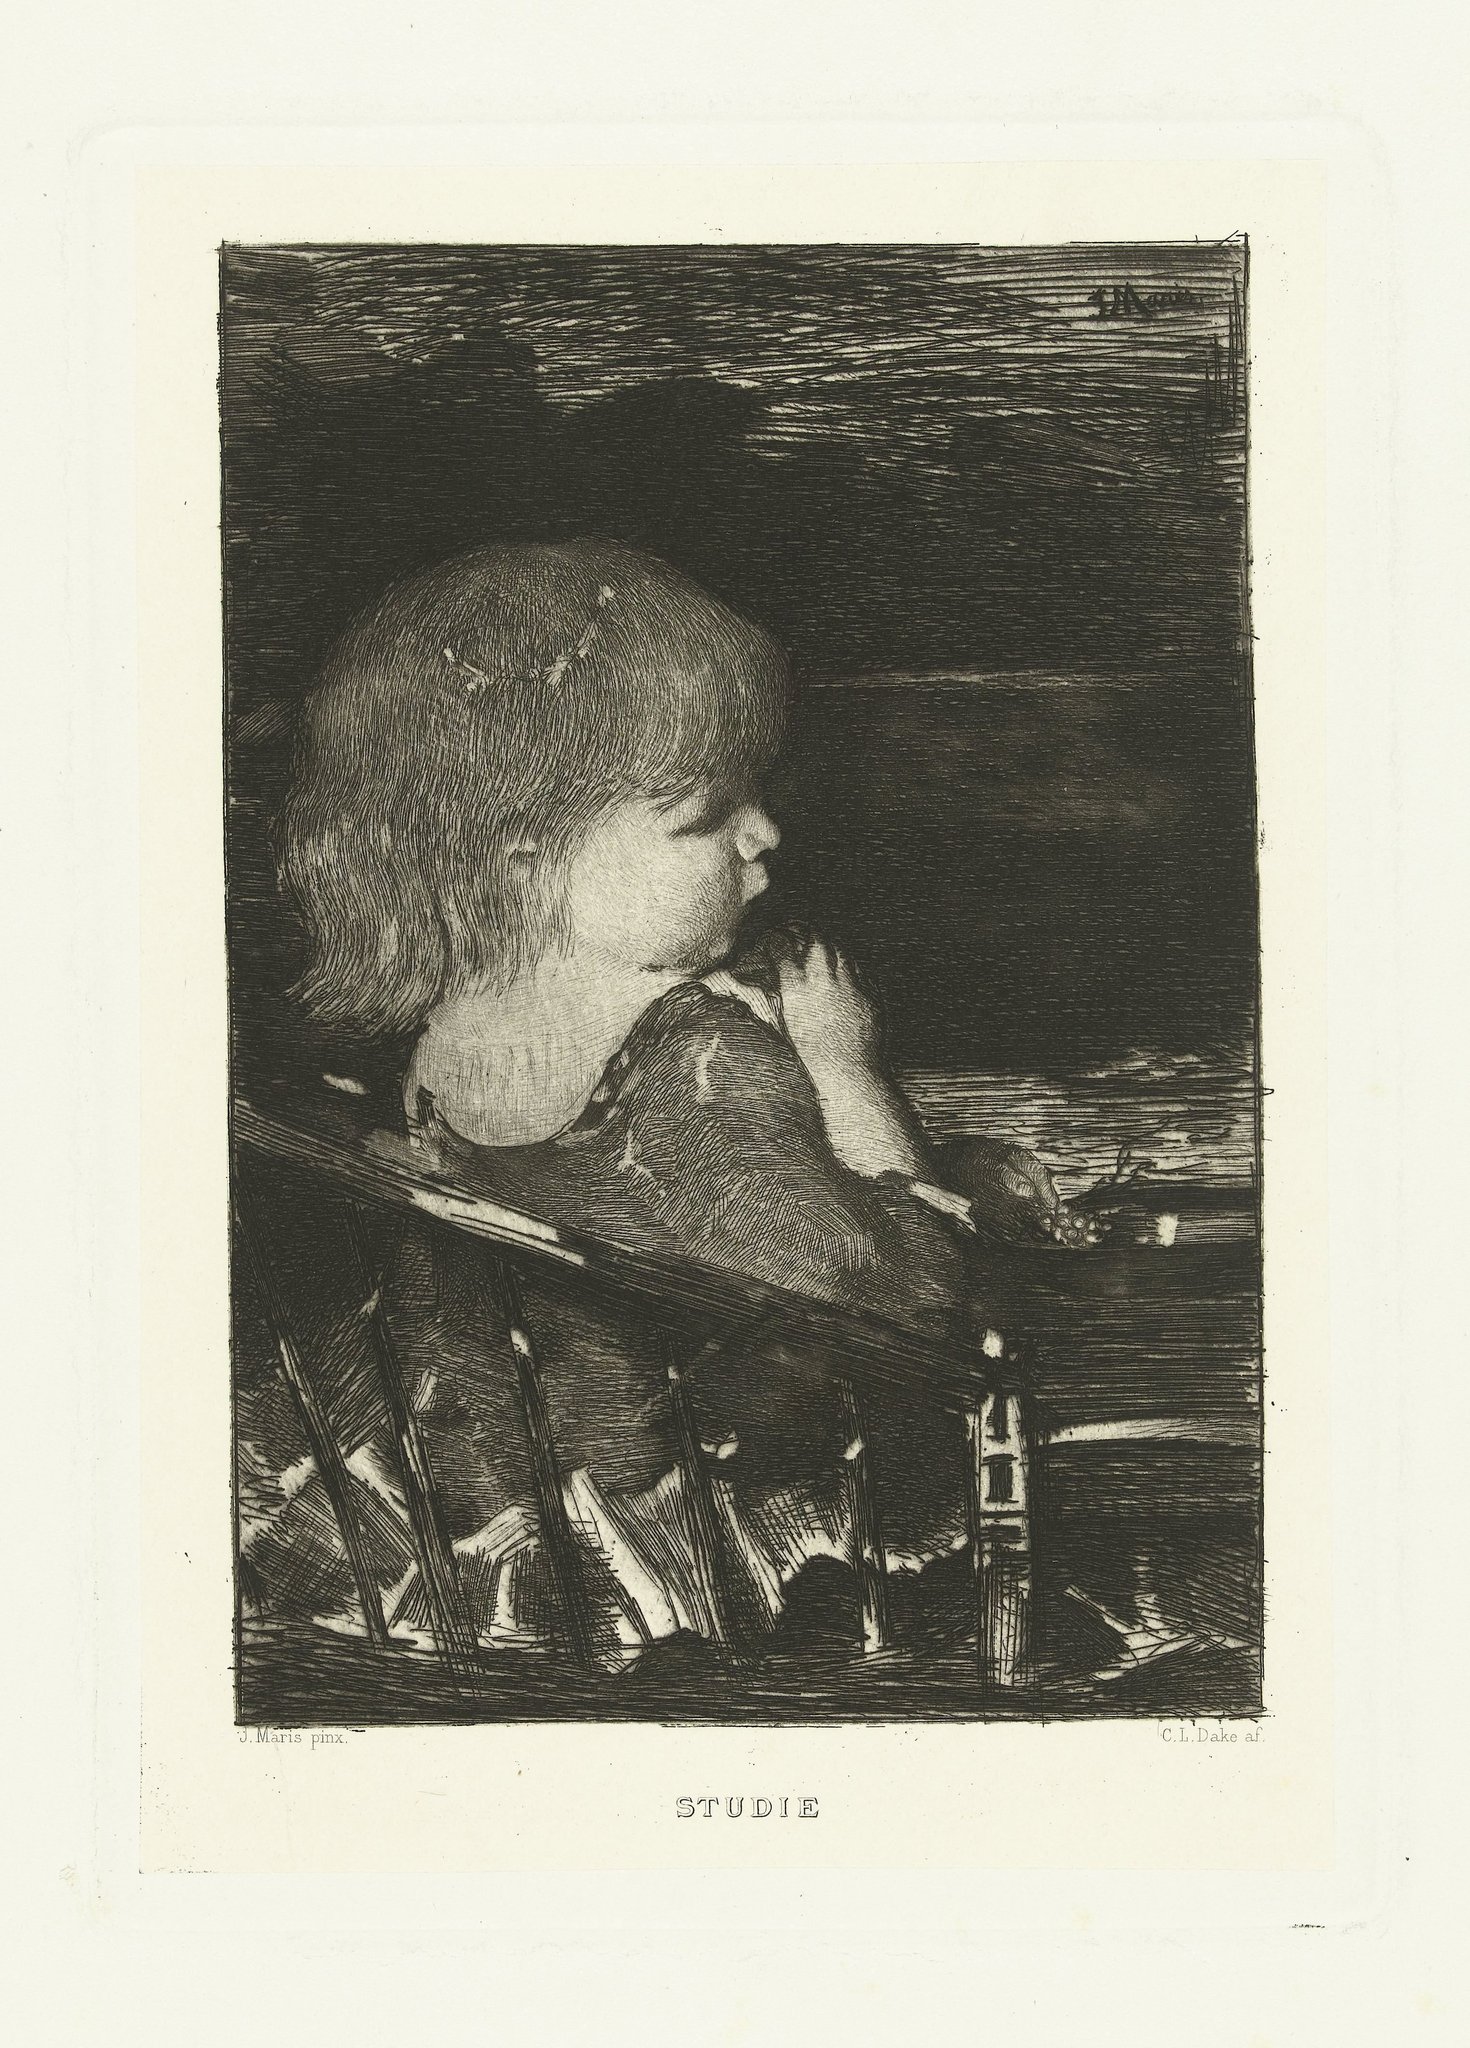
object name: print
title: Klein meisje zittend op stoel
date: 1867-1909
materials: paper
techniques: drypoint, etching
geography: netherlands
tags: girl (child between toddler and youth)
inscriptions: collector's mark: Lugt 2228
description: Collectie de la Faille. Prent naar schilderij van Jacob Maris.